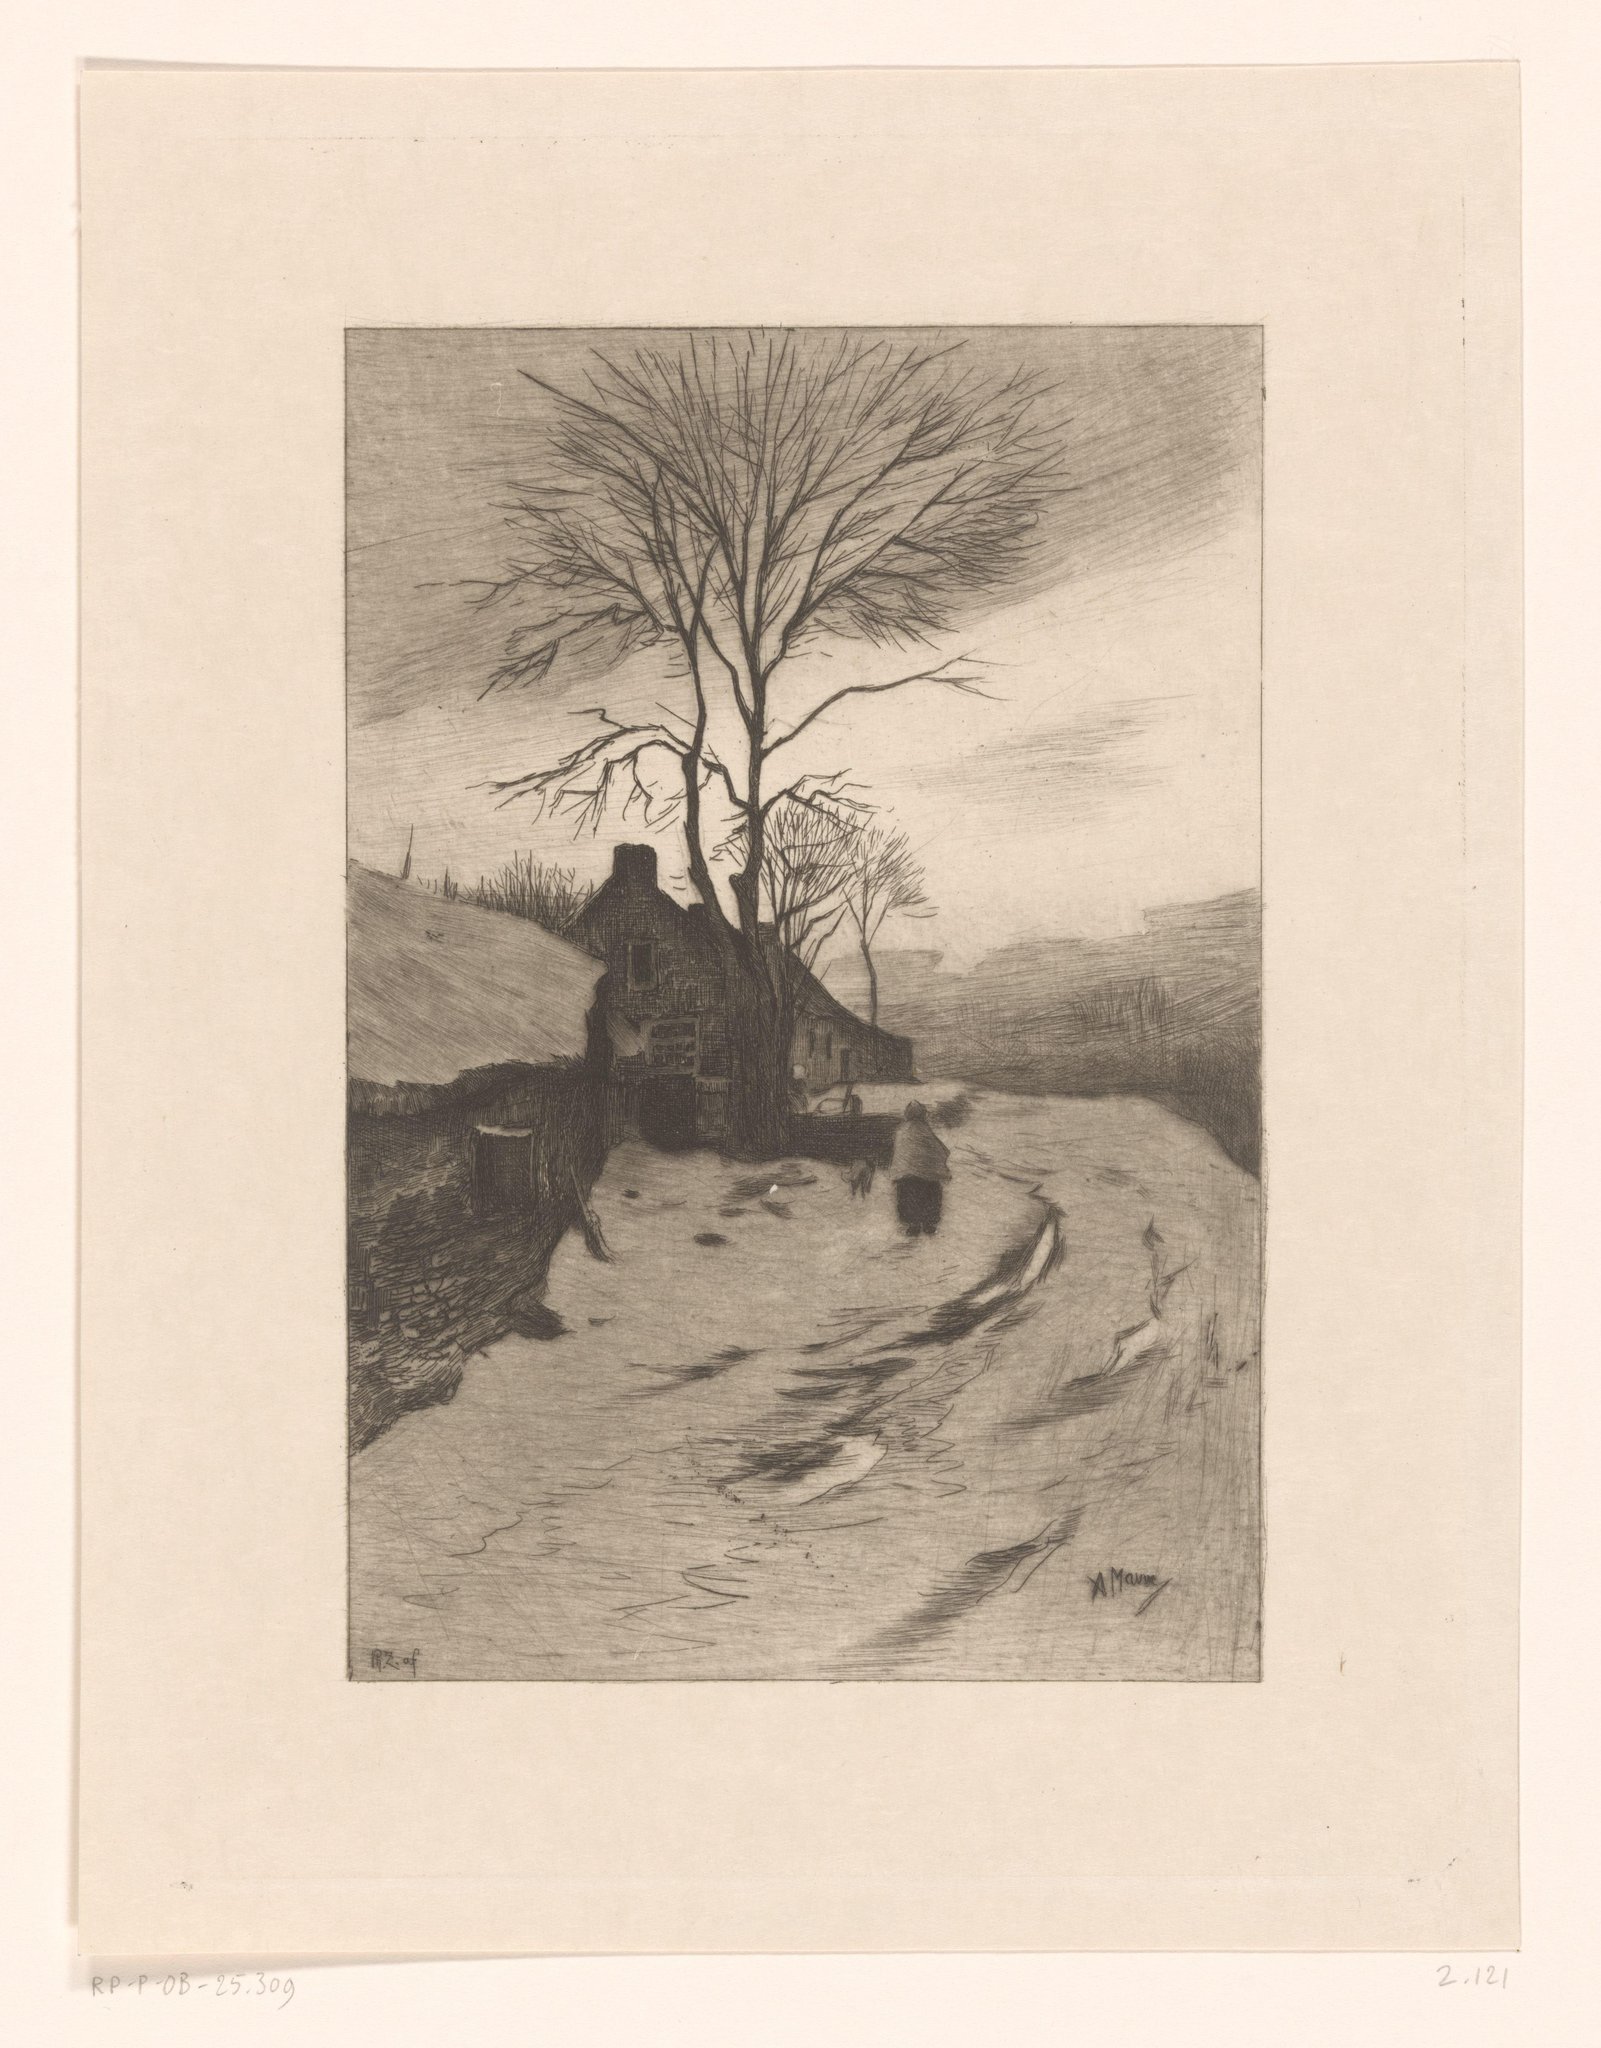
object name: print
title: Boerderijen langs een weg met kale bomen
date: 1867-1890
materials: paper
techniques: drypoint, etching, intaglio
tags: road, path, farm (building)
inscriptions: collector's mark: Lugt 2228